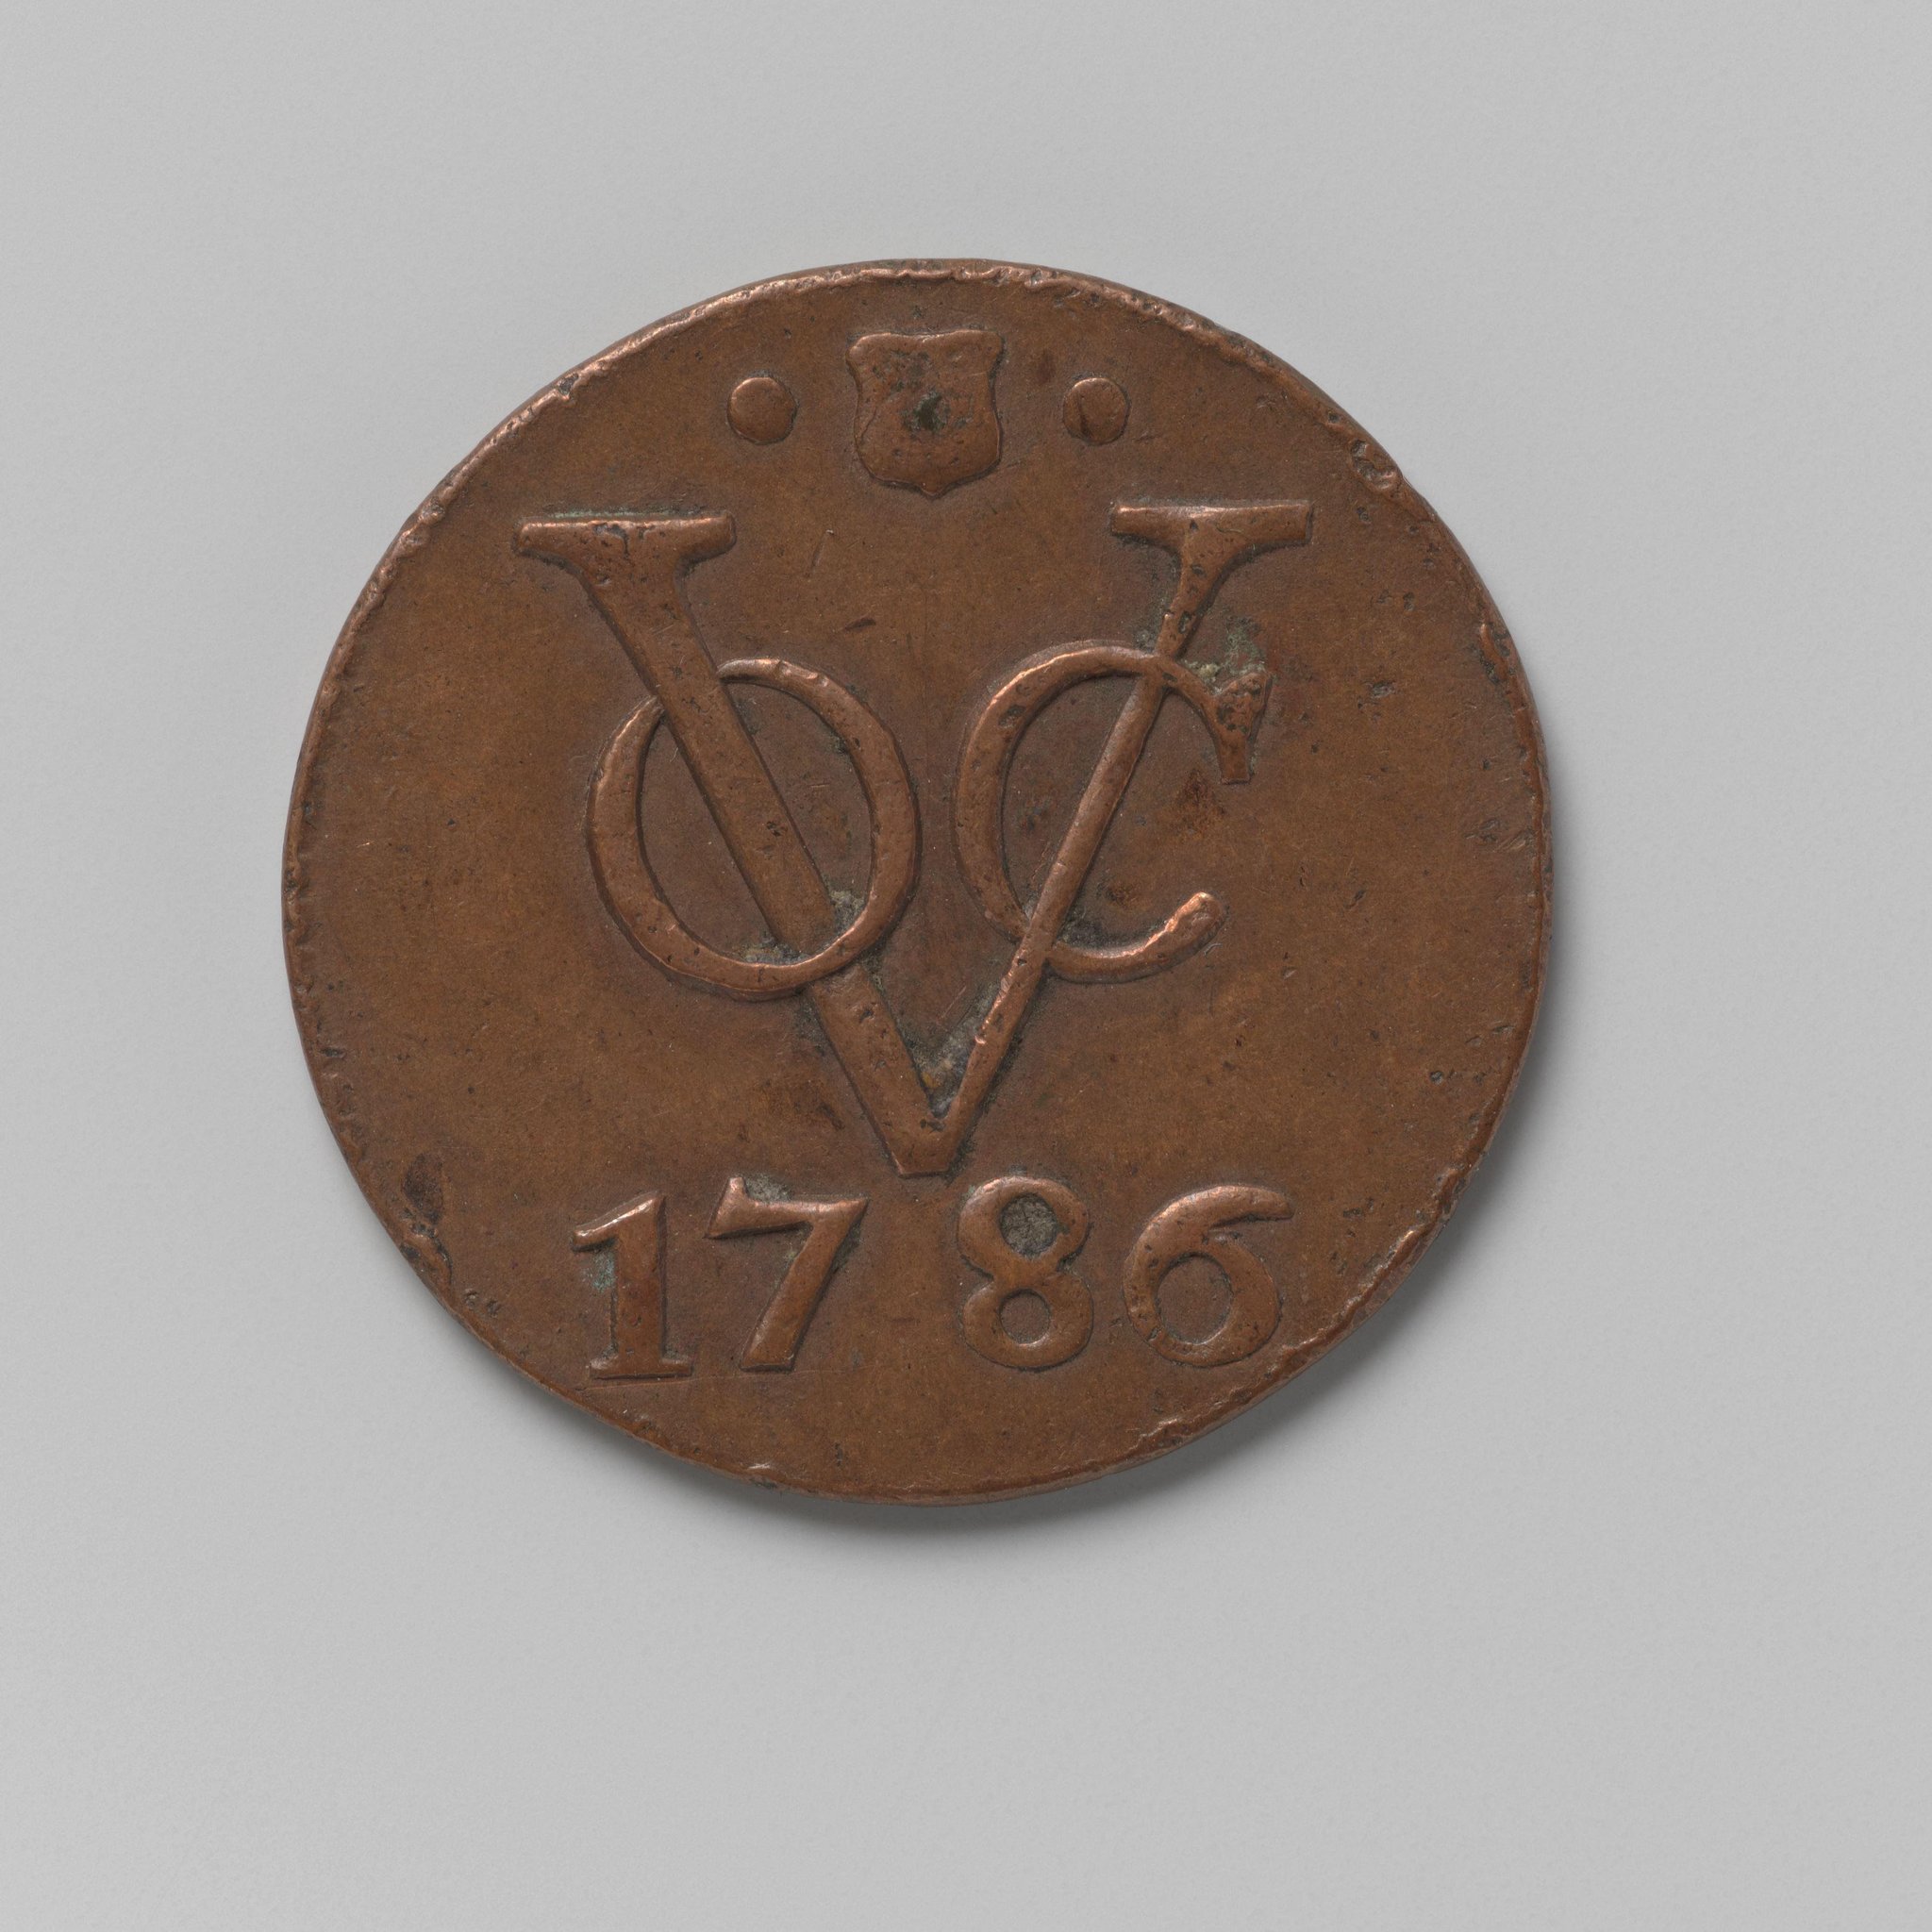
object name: coin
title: Duit van de VOC uit de stad Utrecht,1786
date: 1786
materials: copper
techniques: striking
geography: utrecht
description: Koperen munt. Voorzijde:op balk, waaronder guirlande, staand, door twee leeuwen gehouden gekroond wapenschild van de stad Utrecht. Keerzijde: monogram van de VOC, waarboven muntteken en waaronder jaartal. Gladde rand.